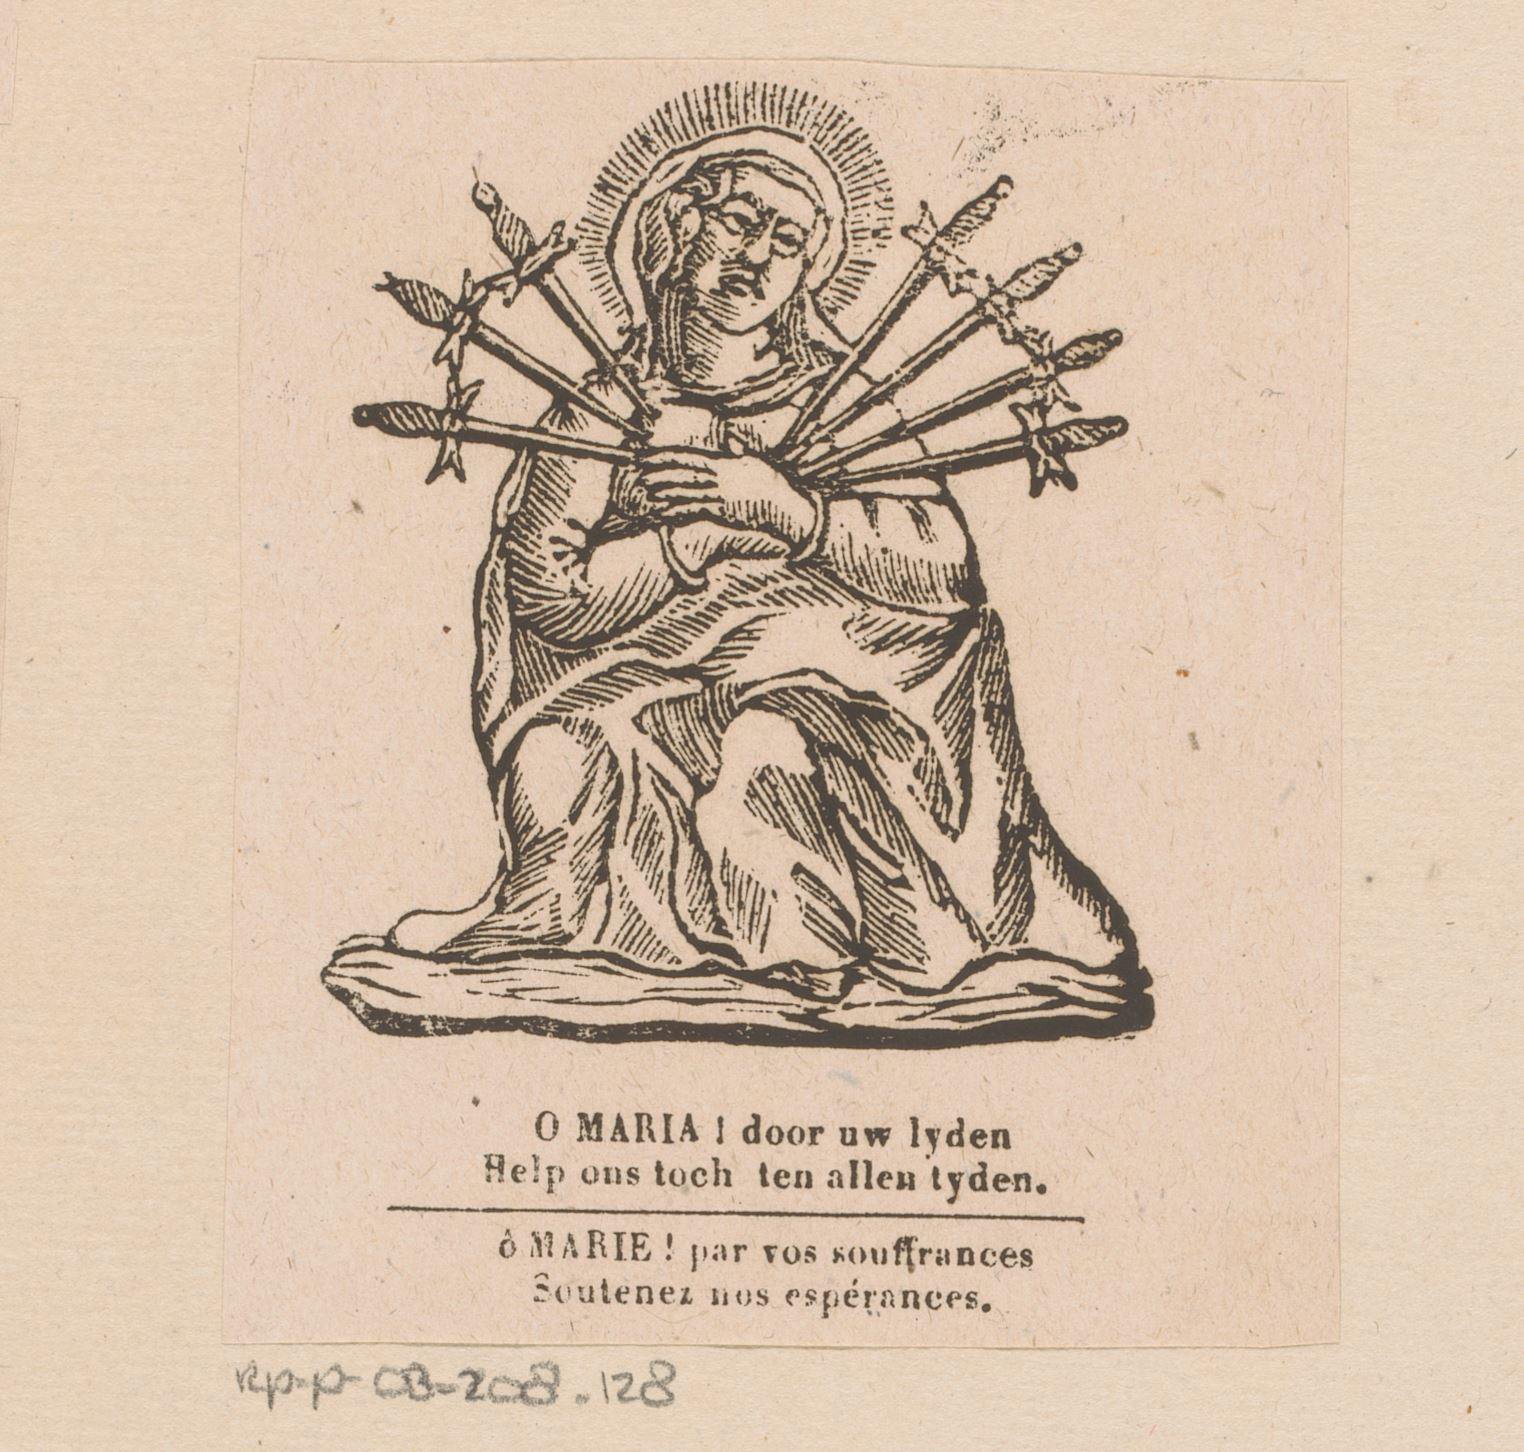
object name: print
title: Maria van de zeven smarten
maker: Anonymous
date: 1600-1699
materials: paper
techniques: letterpress printing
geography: netherlands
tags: mary pierced by seven swords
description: Zittende Maria, doorstoken met zeven zwaarden, die verwijzen naar de zeven smarten van Maria.